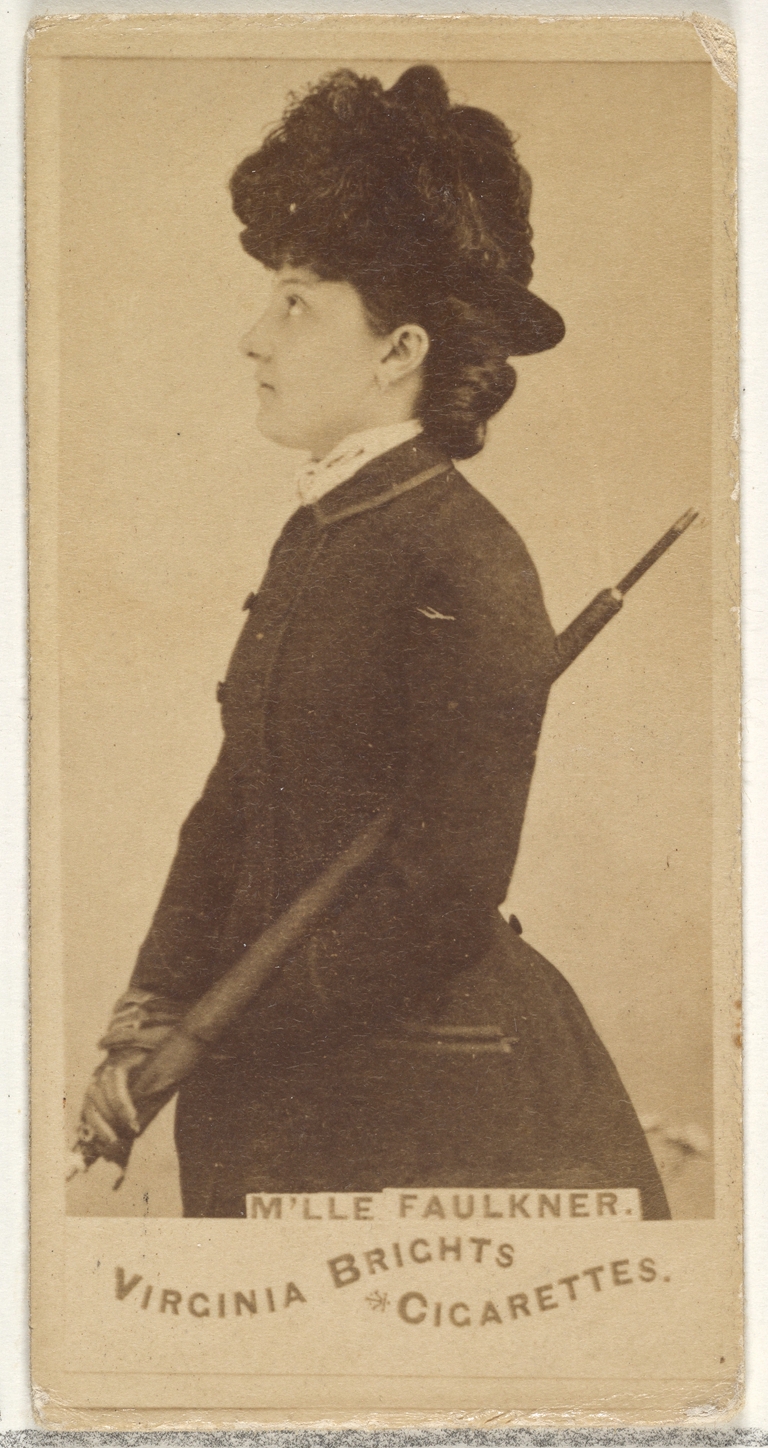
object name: photograph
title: Mlle. Faulkner, from the Actors and Actresses series (N45, Type 1) for Virginia Brights Cigarettes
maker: allen & ginter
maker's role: publisher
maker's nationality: american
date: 1888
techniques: albumen silver print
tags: portraits,profiles,women,actresses